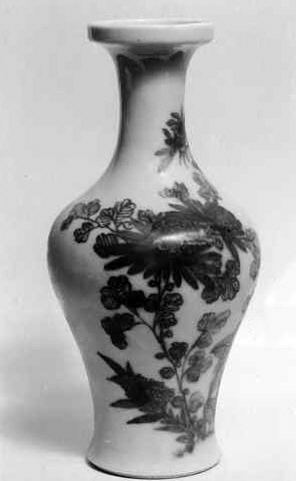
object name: vase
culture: chinese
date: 1662-1722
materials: porcelain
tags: flowers,plants